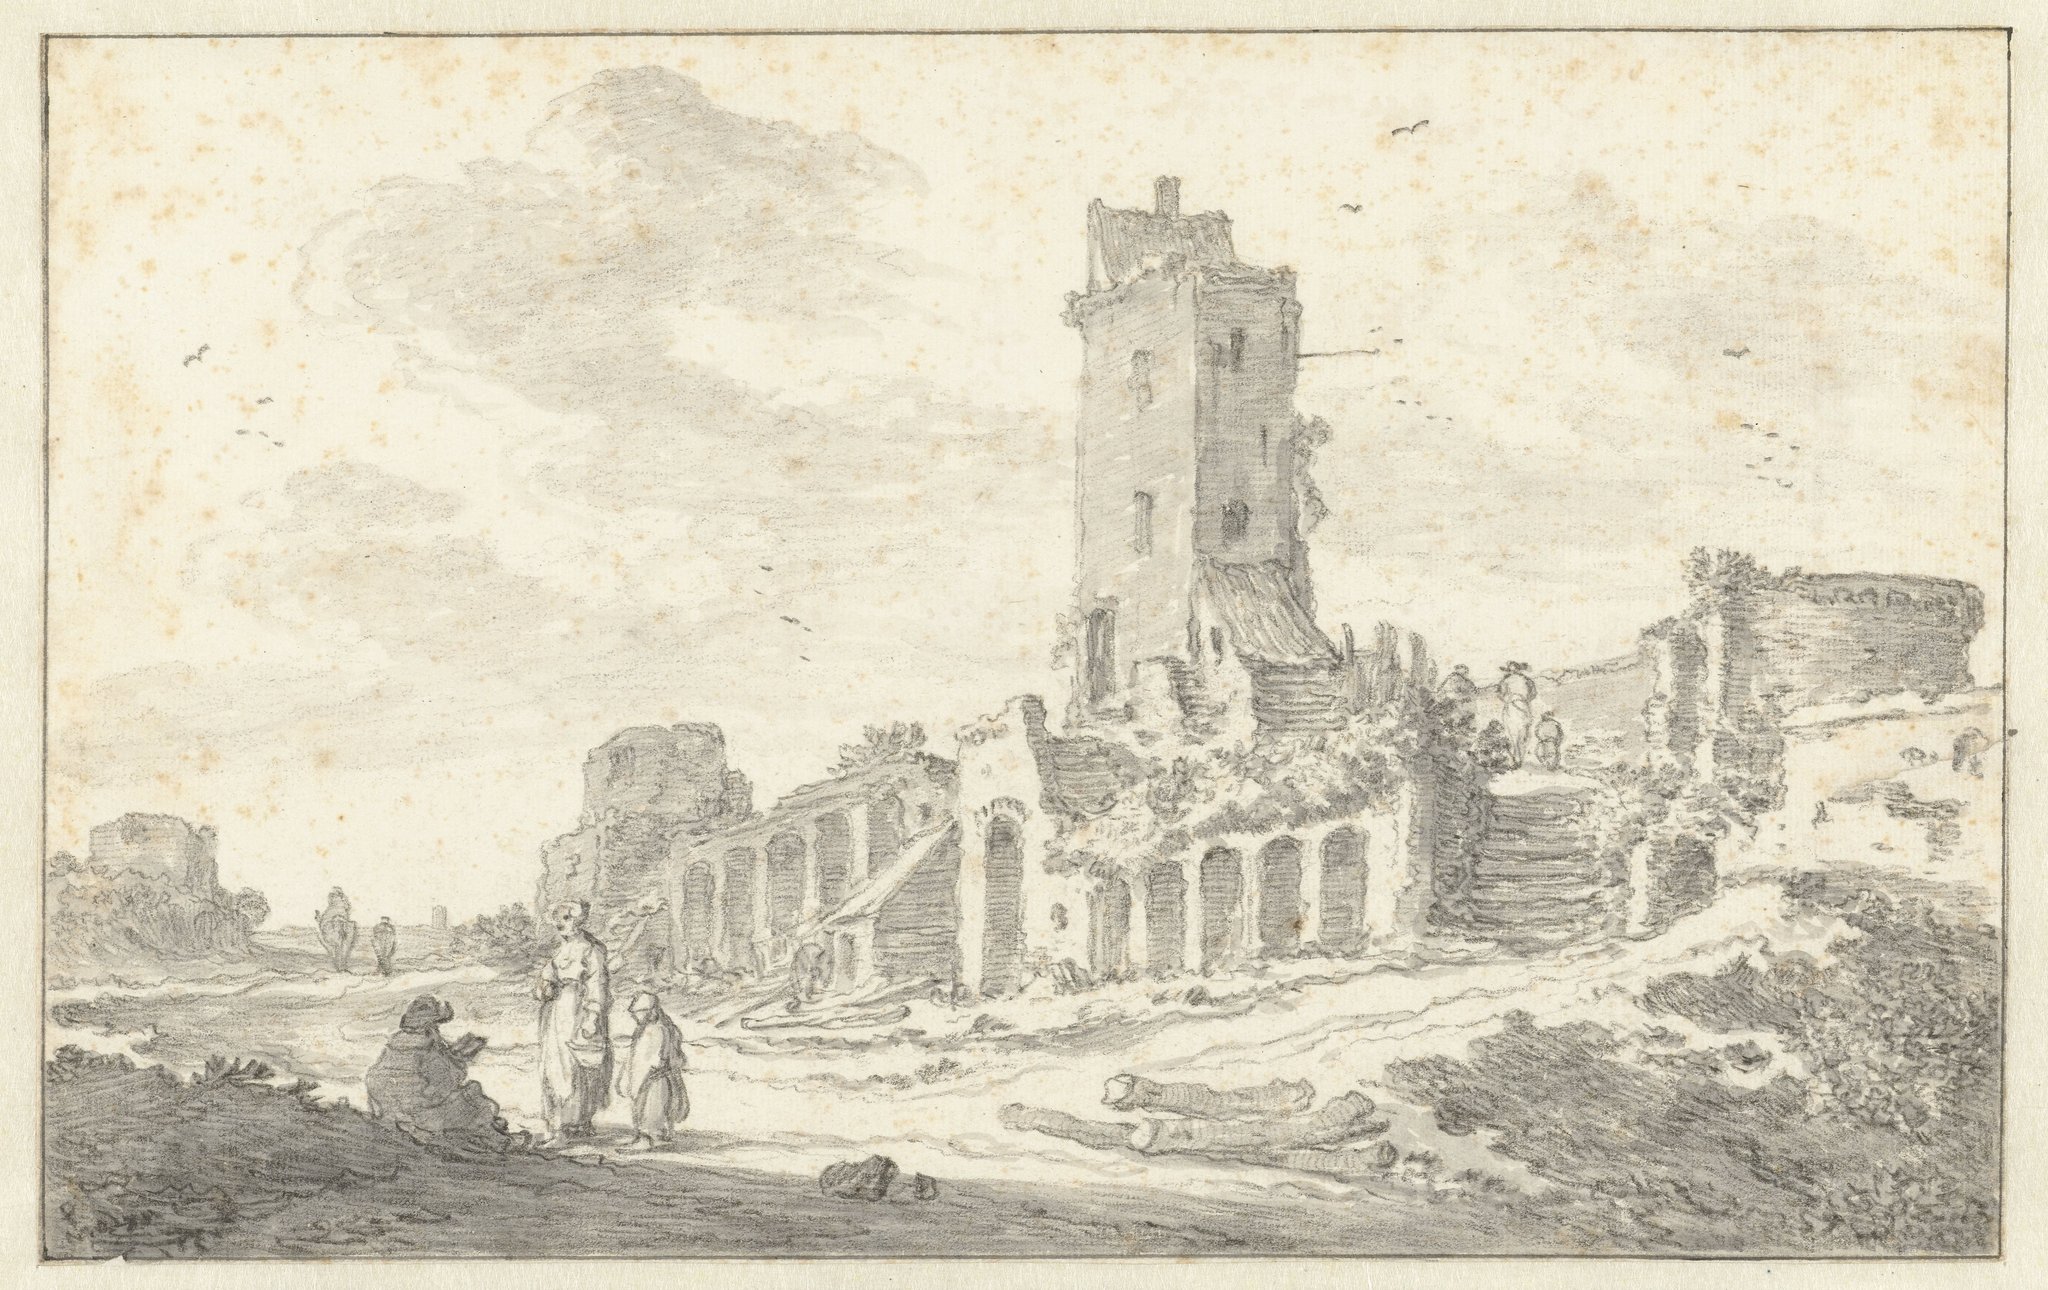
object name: drawing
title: Ruïne met hoge vierkante toren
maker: pieter de molijn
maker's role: draughtsman, painter, print maker, publisher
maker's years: 1595-1661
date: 1650-1660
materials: chalk, paper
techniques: brush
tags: ruin of a building ~ architecture, landscape with ruins